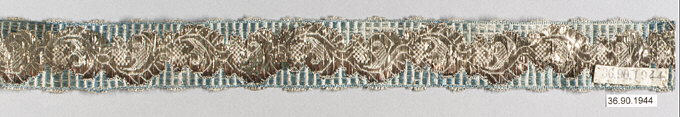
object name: galloon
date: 1701-1800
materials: metal thread, silk